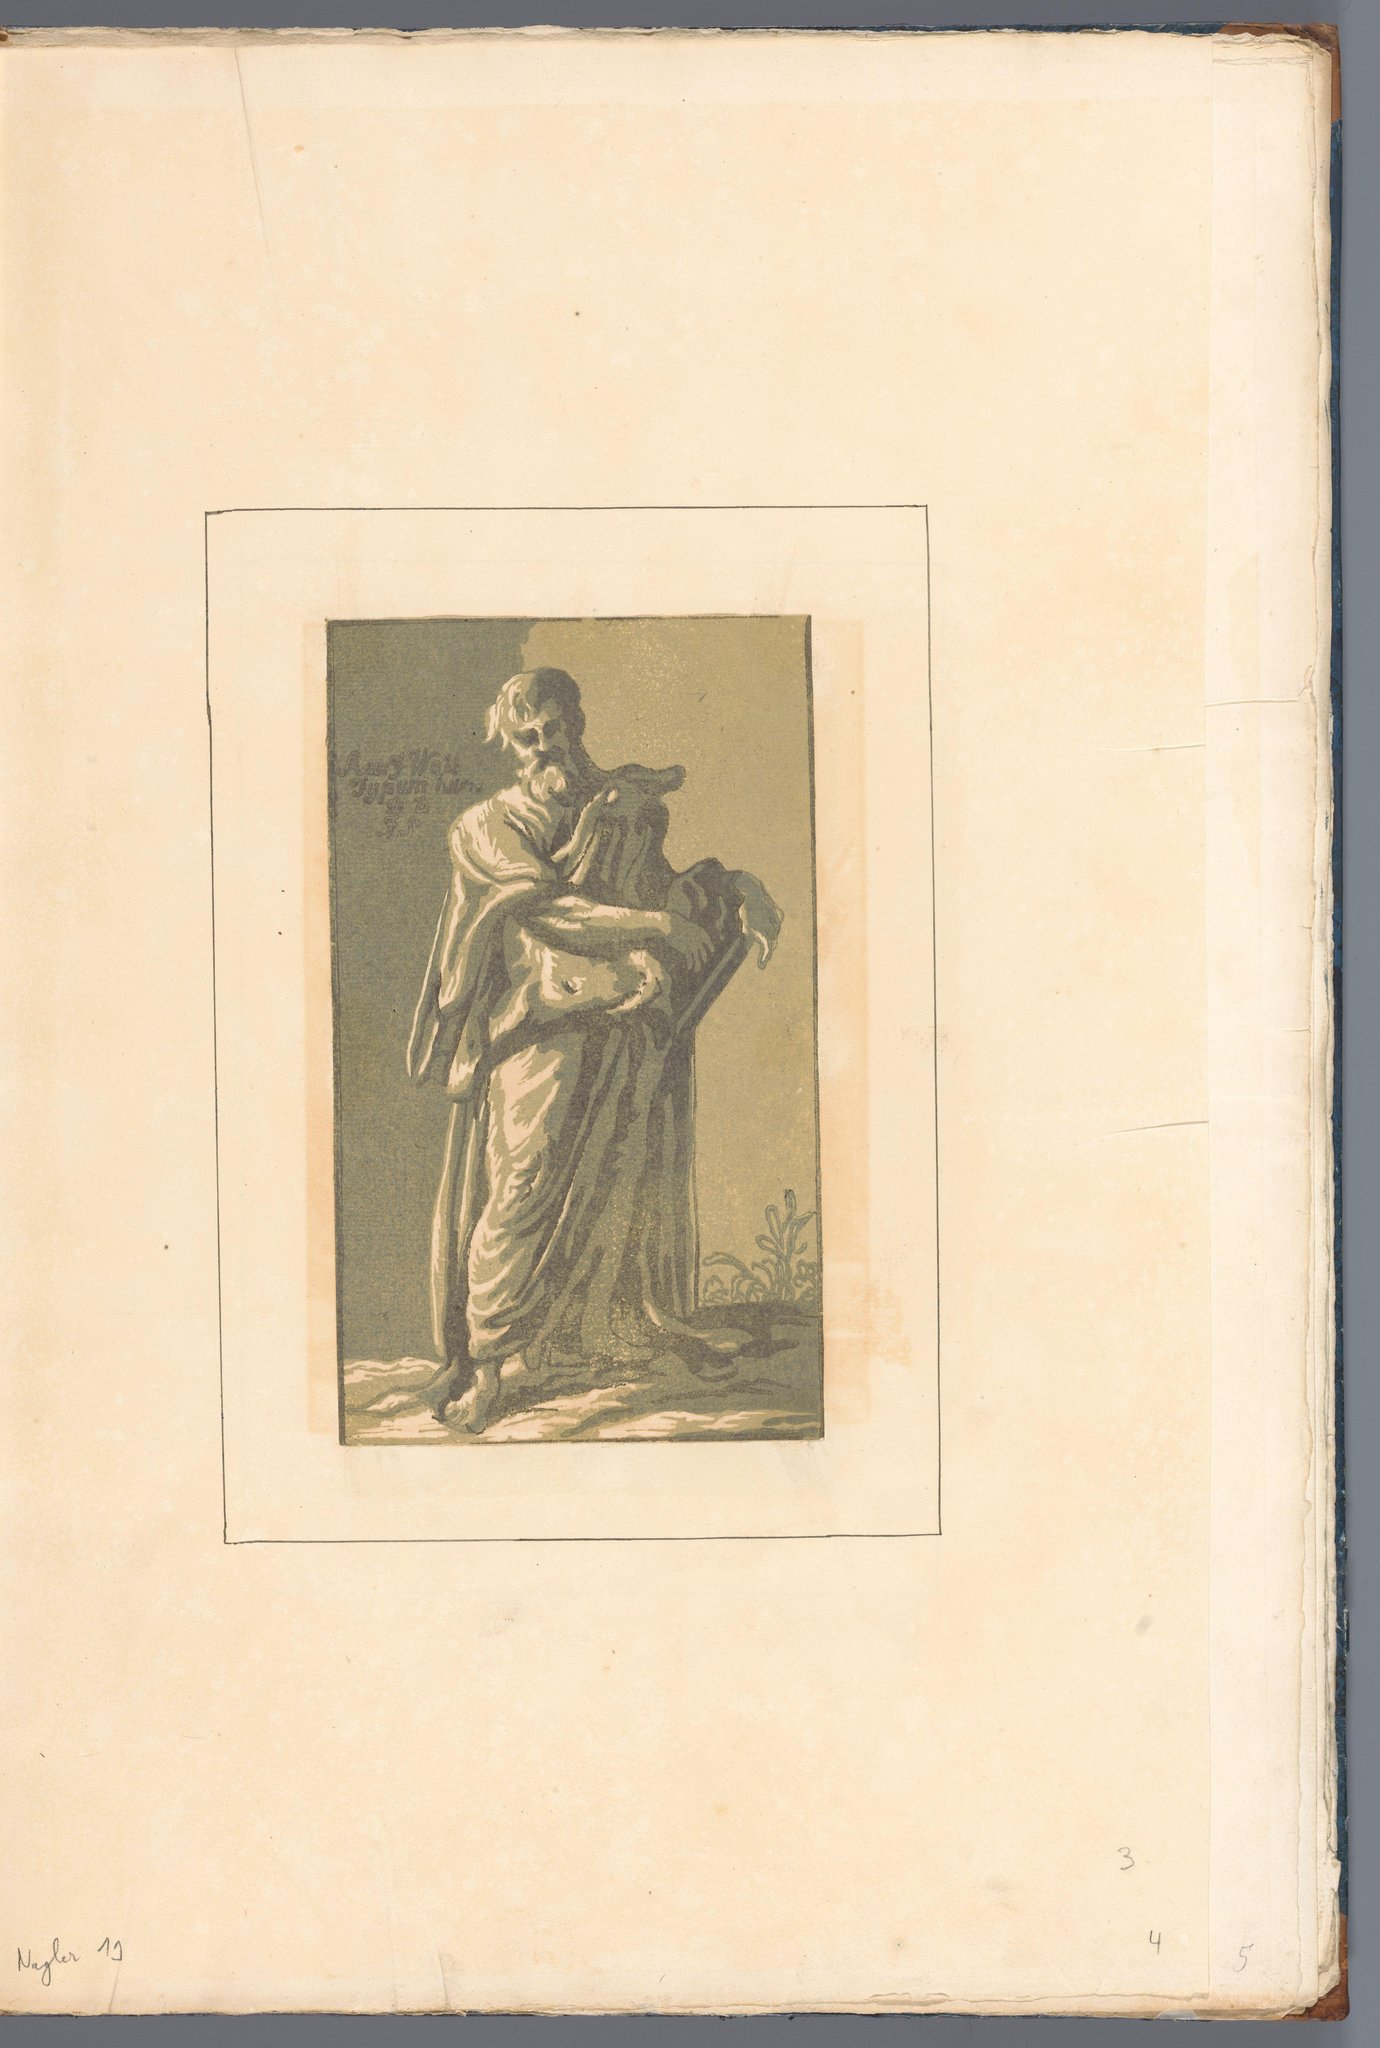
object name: print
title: Staande heilige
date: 1781-1783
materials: ink, paper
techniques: woodcut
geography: england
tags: standing figure, saints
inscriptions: dedication: ‘Rev: J. Webb / Typum ... / DD / JS’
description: Staande man met baard, waarschijnlijk een apostel of heilige. Onderdeel van een album met 26 ingeplakte clair-obscur houtsneden naar Italiaanse kunstenaars uit de zestiende eeuw.